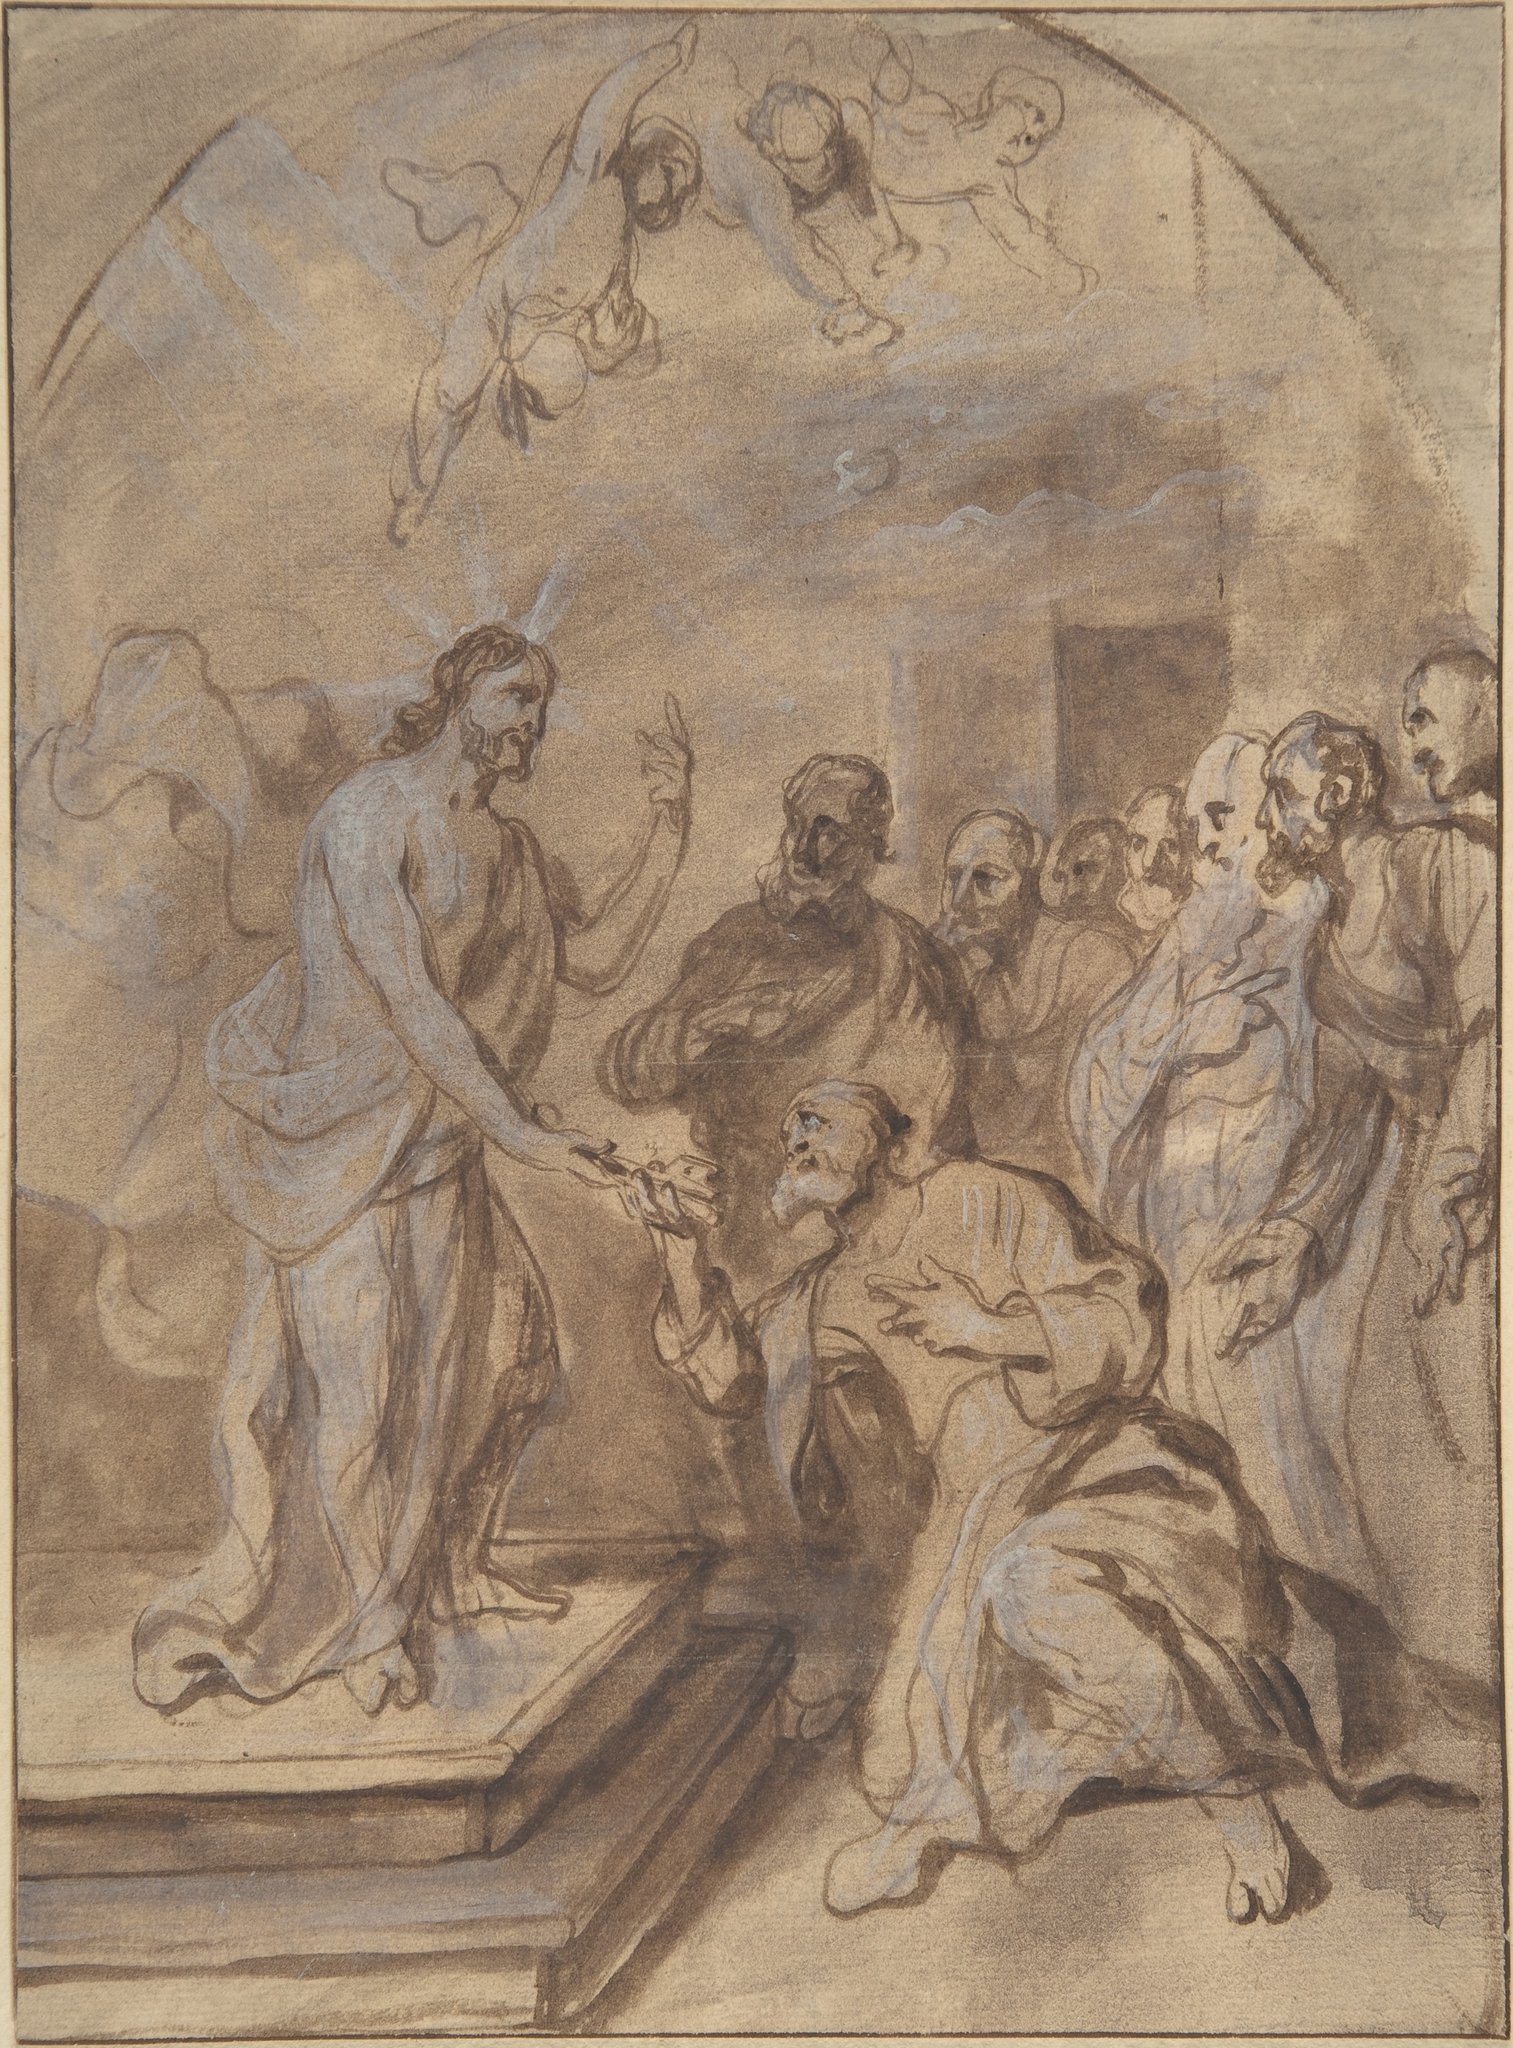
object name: drawing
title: The Delivery of the Keys to Saint Peter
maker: jan boeckhorst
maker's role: artist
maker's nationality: flemish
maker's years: 1599-1668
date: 1660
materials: ink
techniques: brush, heightening, wash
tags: christ,saint peter,keys